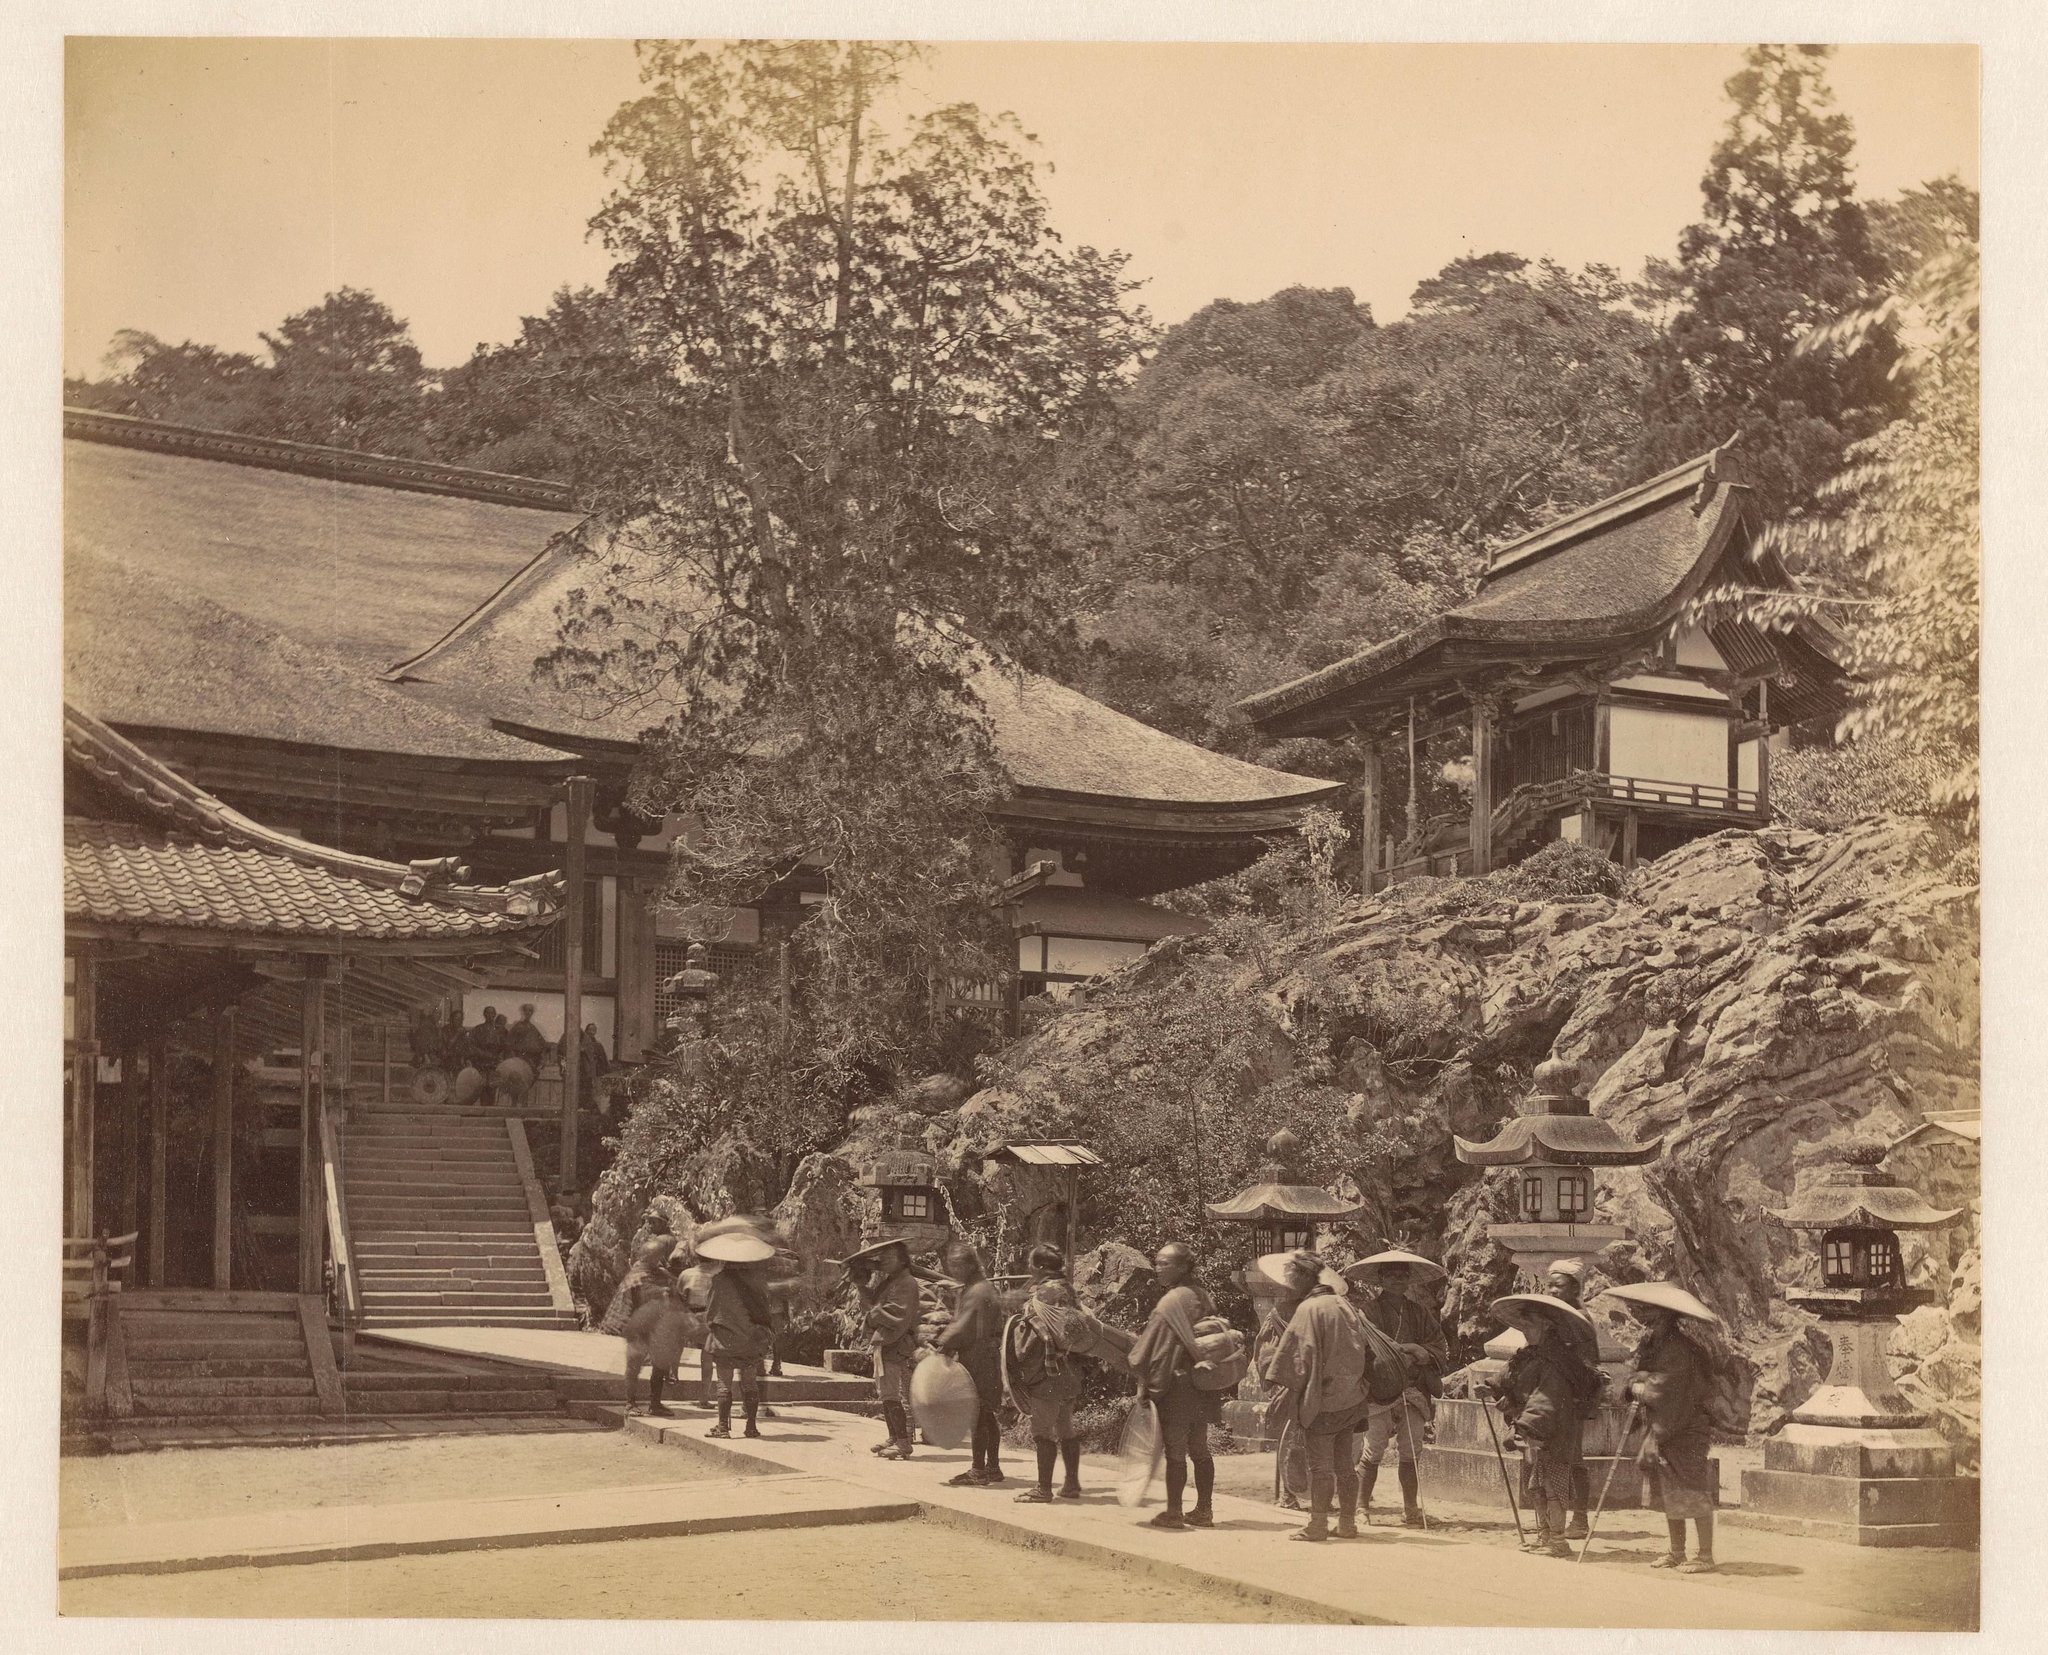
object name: photograph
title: Japanners bij een tempelcomplex in Japan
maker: felice beato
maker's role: fotograaf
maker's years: 1825-1909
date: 1863-1877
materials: cardboard, paper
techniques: albumen print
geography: japan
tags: 'en route', traveller under way, japan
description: Mensen in traditionele Japanse kleding met grote strohoeden en bepakking op de rug komen lopend aan bij een tempelcomplex.